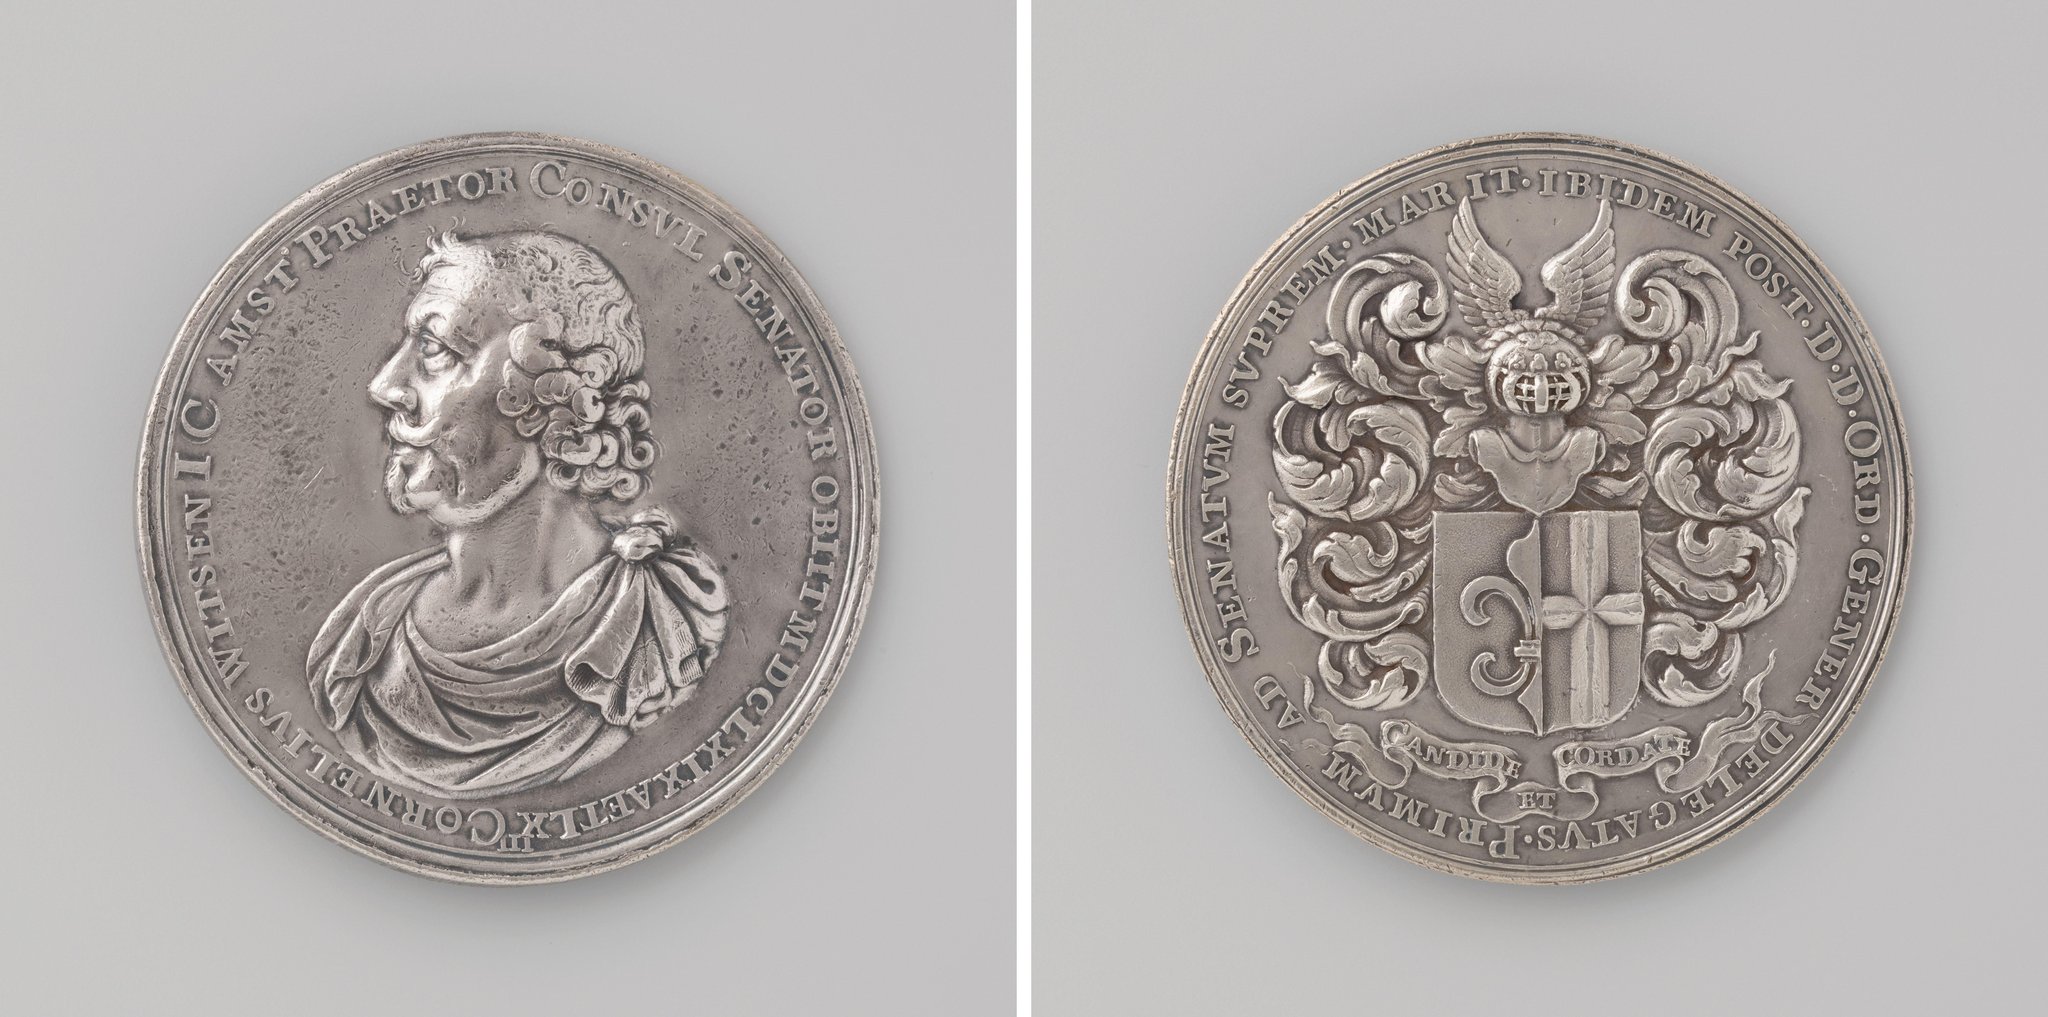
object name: history medal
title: Dood van Cornelis Witsen, burgemeester van Amsterdam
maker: Anonymous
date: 1669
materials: silver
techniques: striking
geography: netherlands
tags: amsterdam, mayor, cornelis witsen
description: Zilveren penning. Voorzijde: borststuk man binnen omschrift. Keerzijde: gehelmd wapenschild binnen omschrift